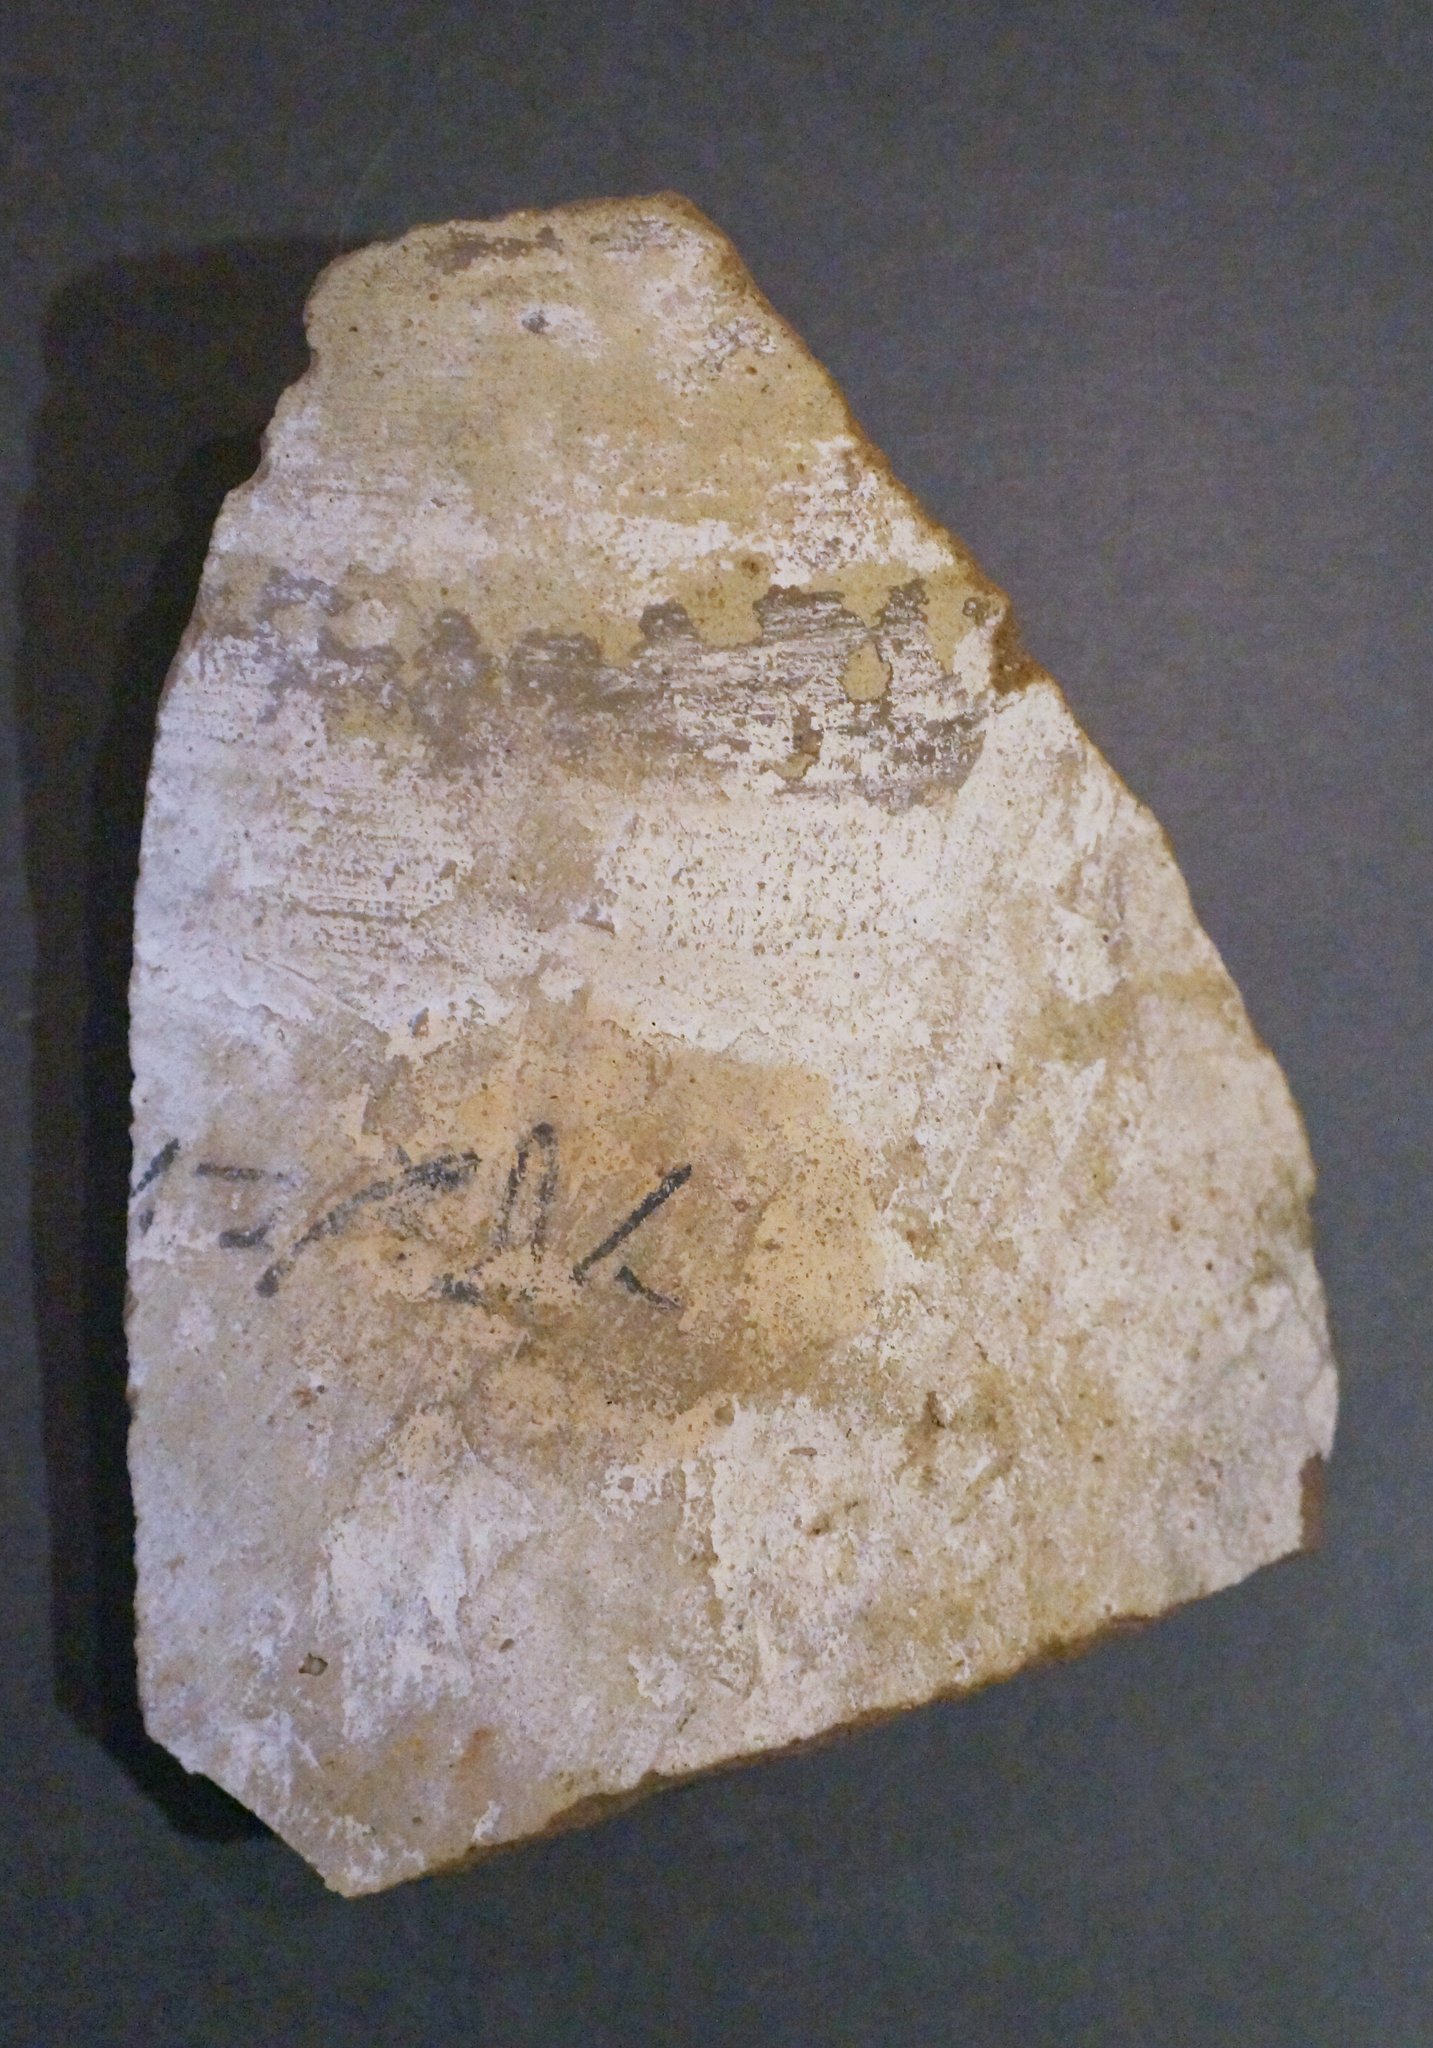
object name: jar label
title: Inscribed Pot Fragment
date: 1580-1479 BCE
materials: ink, pottery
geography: egypt